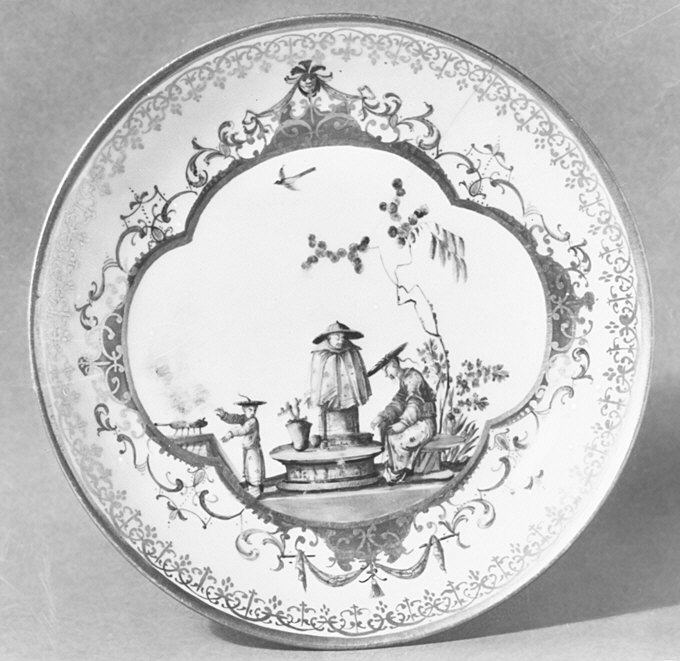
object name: saucer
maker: meissen manufactory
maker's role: manufactory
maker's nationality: german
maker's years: 1710-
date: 1730-1735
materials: hard paste porcelain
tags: birds,men